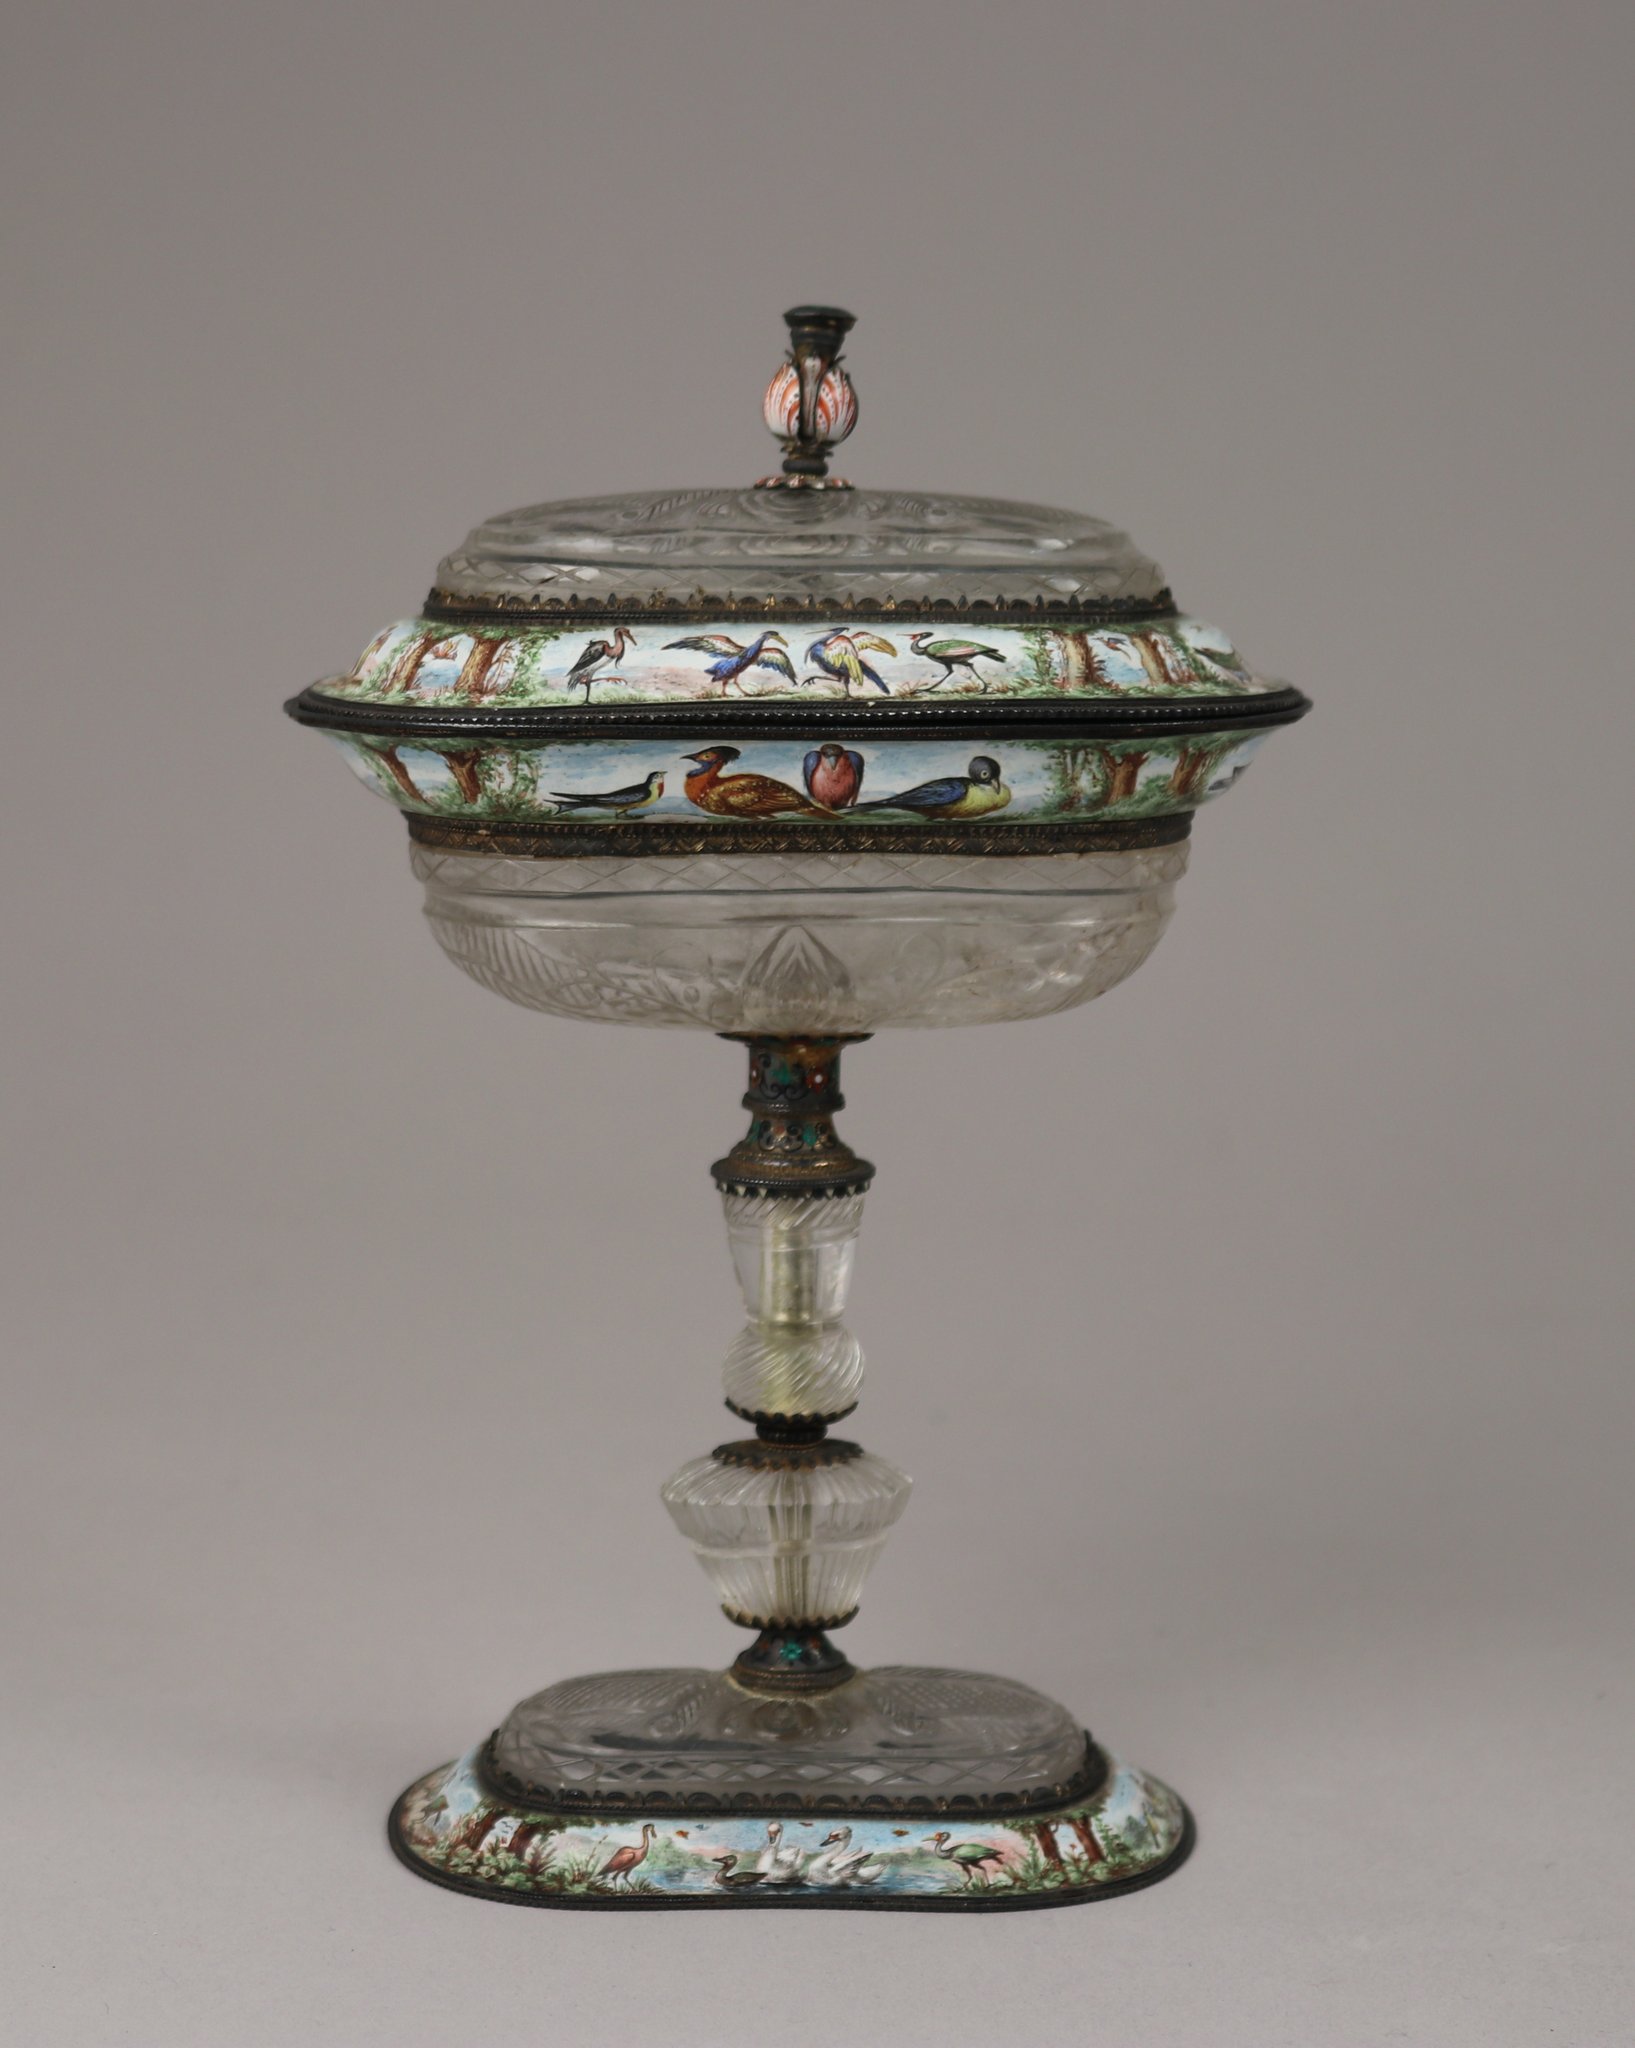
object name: standing cup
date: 1866-1880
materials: enamel, quartz, silver gilt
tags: birds,men